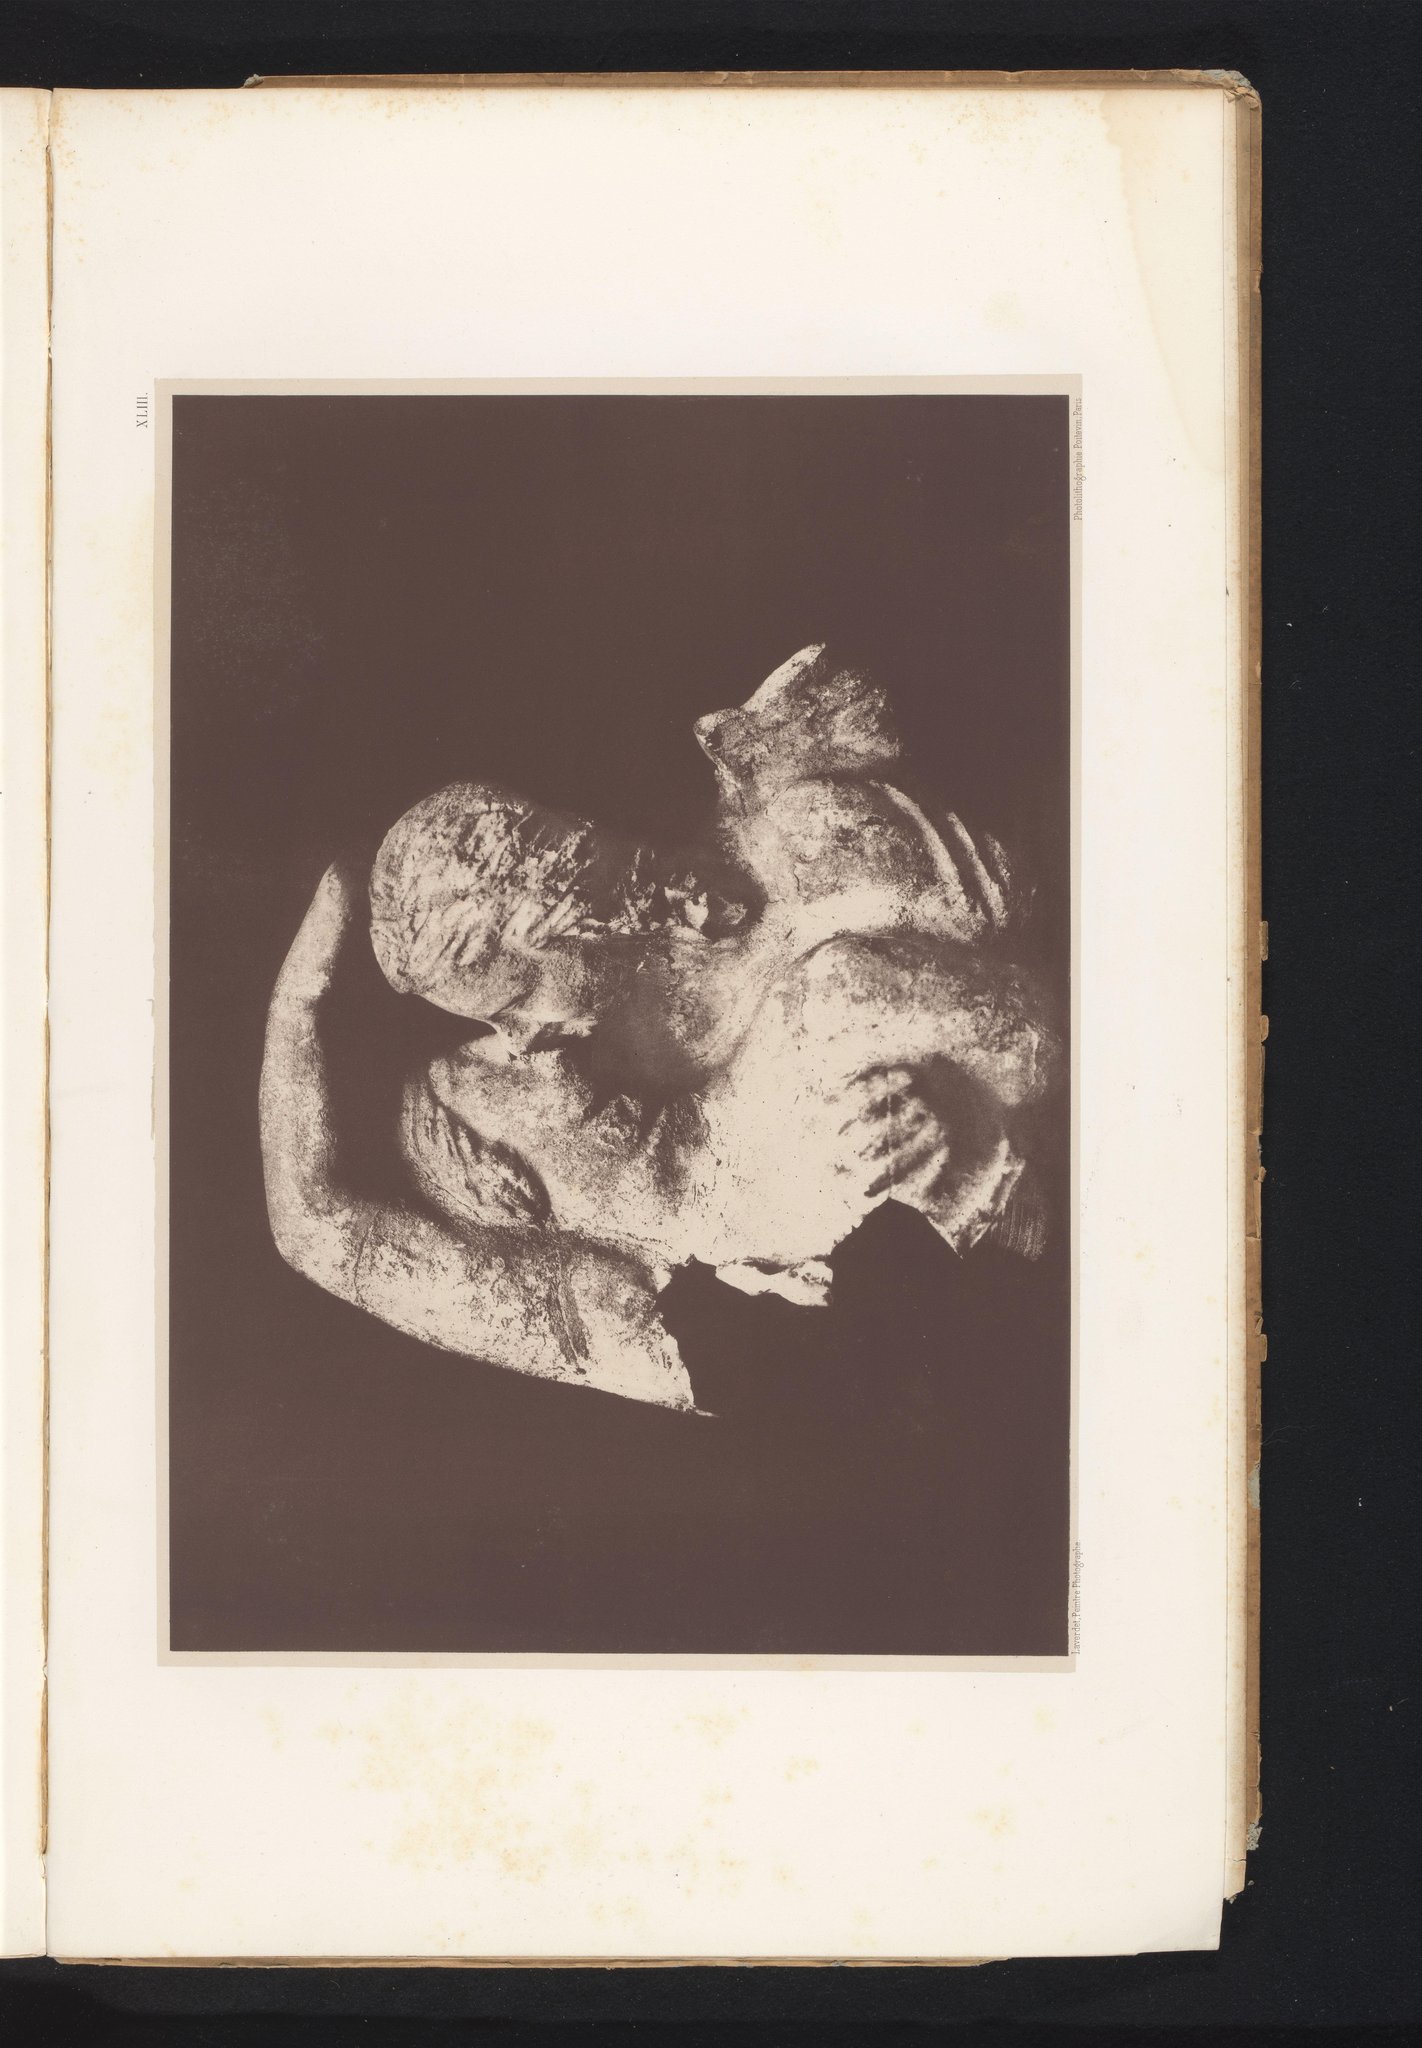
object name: page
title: Terracotta sculptuur van een buste van Psyche en Cupido die elkaar kussen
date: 1852-1857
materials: paper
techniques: photolithography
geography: paris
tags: piece of sculpture, reproduction of a piece of sculpture (+ clay, sand, etc. ~ arts), cupid and psyche as lovers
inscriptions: number: ‘XLIII.’